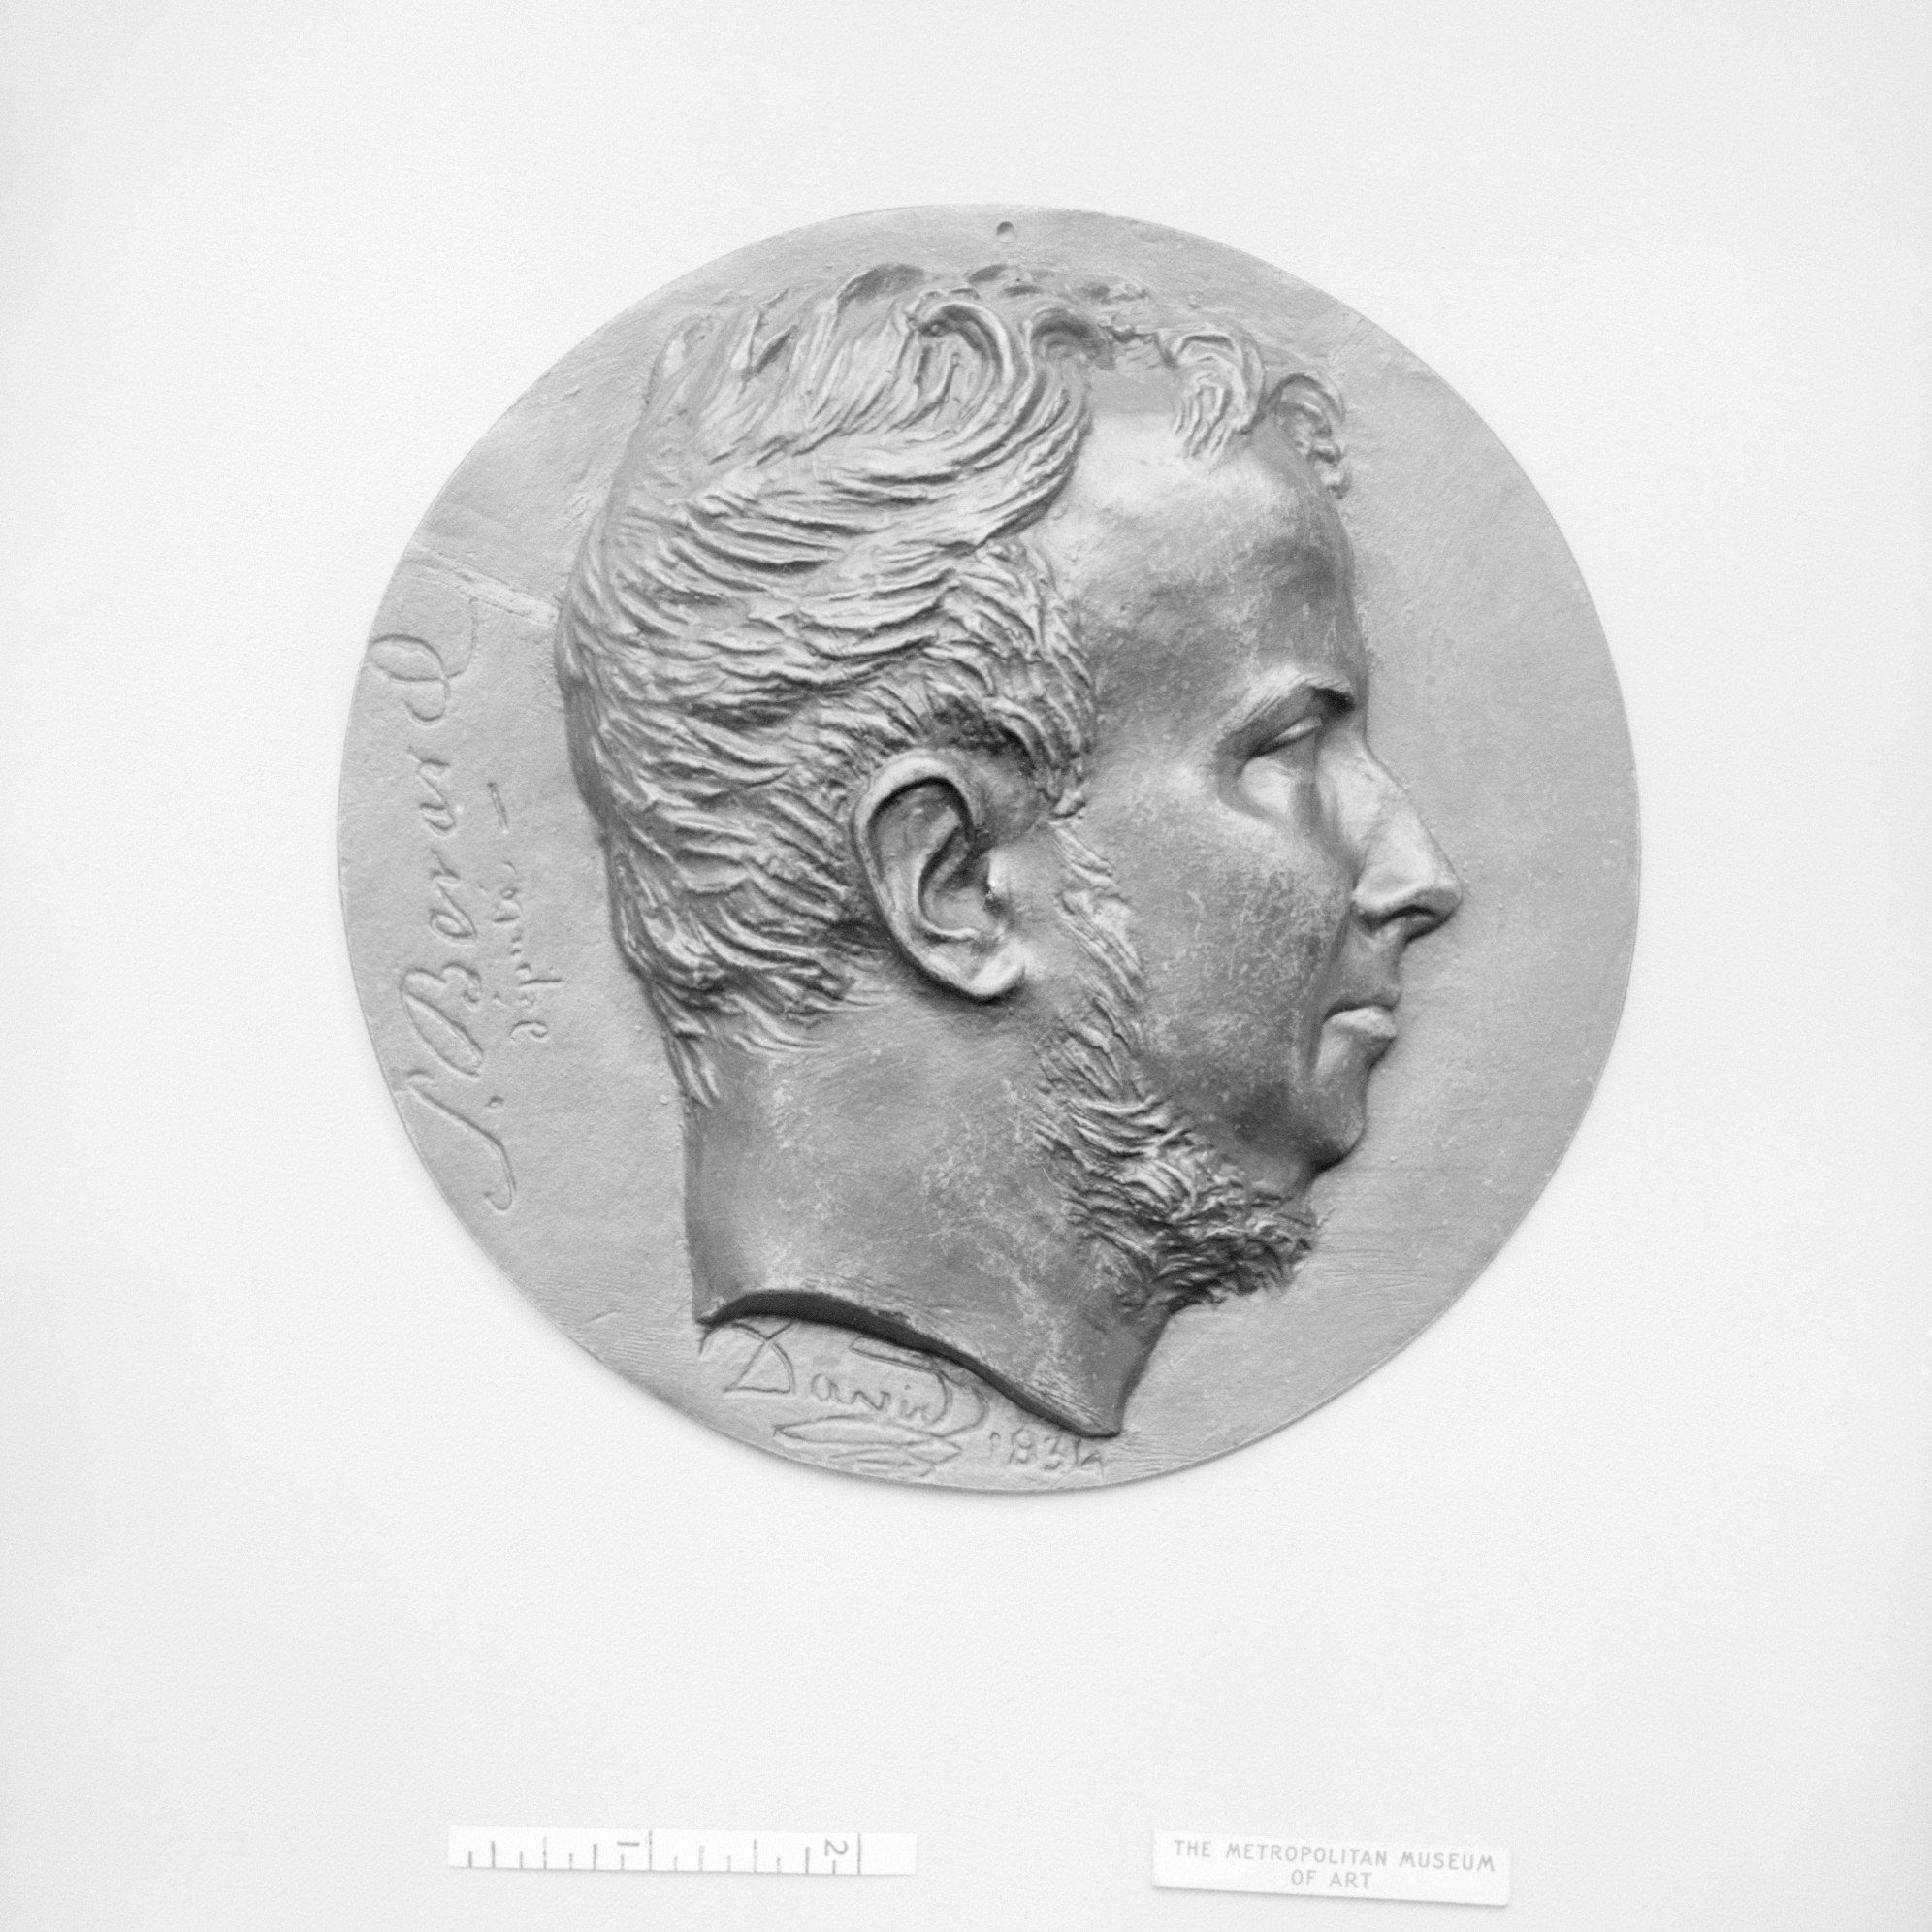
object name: medallion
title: Auguste Simon Louis Berard (1783–1859), French politician, who drew up the "charter" of 1830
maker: pierre jean david d'angers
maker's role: artist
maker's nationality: french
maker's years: 1788-1856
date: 1834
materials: bronze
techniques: casting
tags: men,profiles